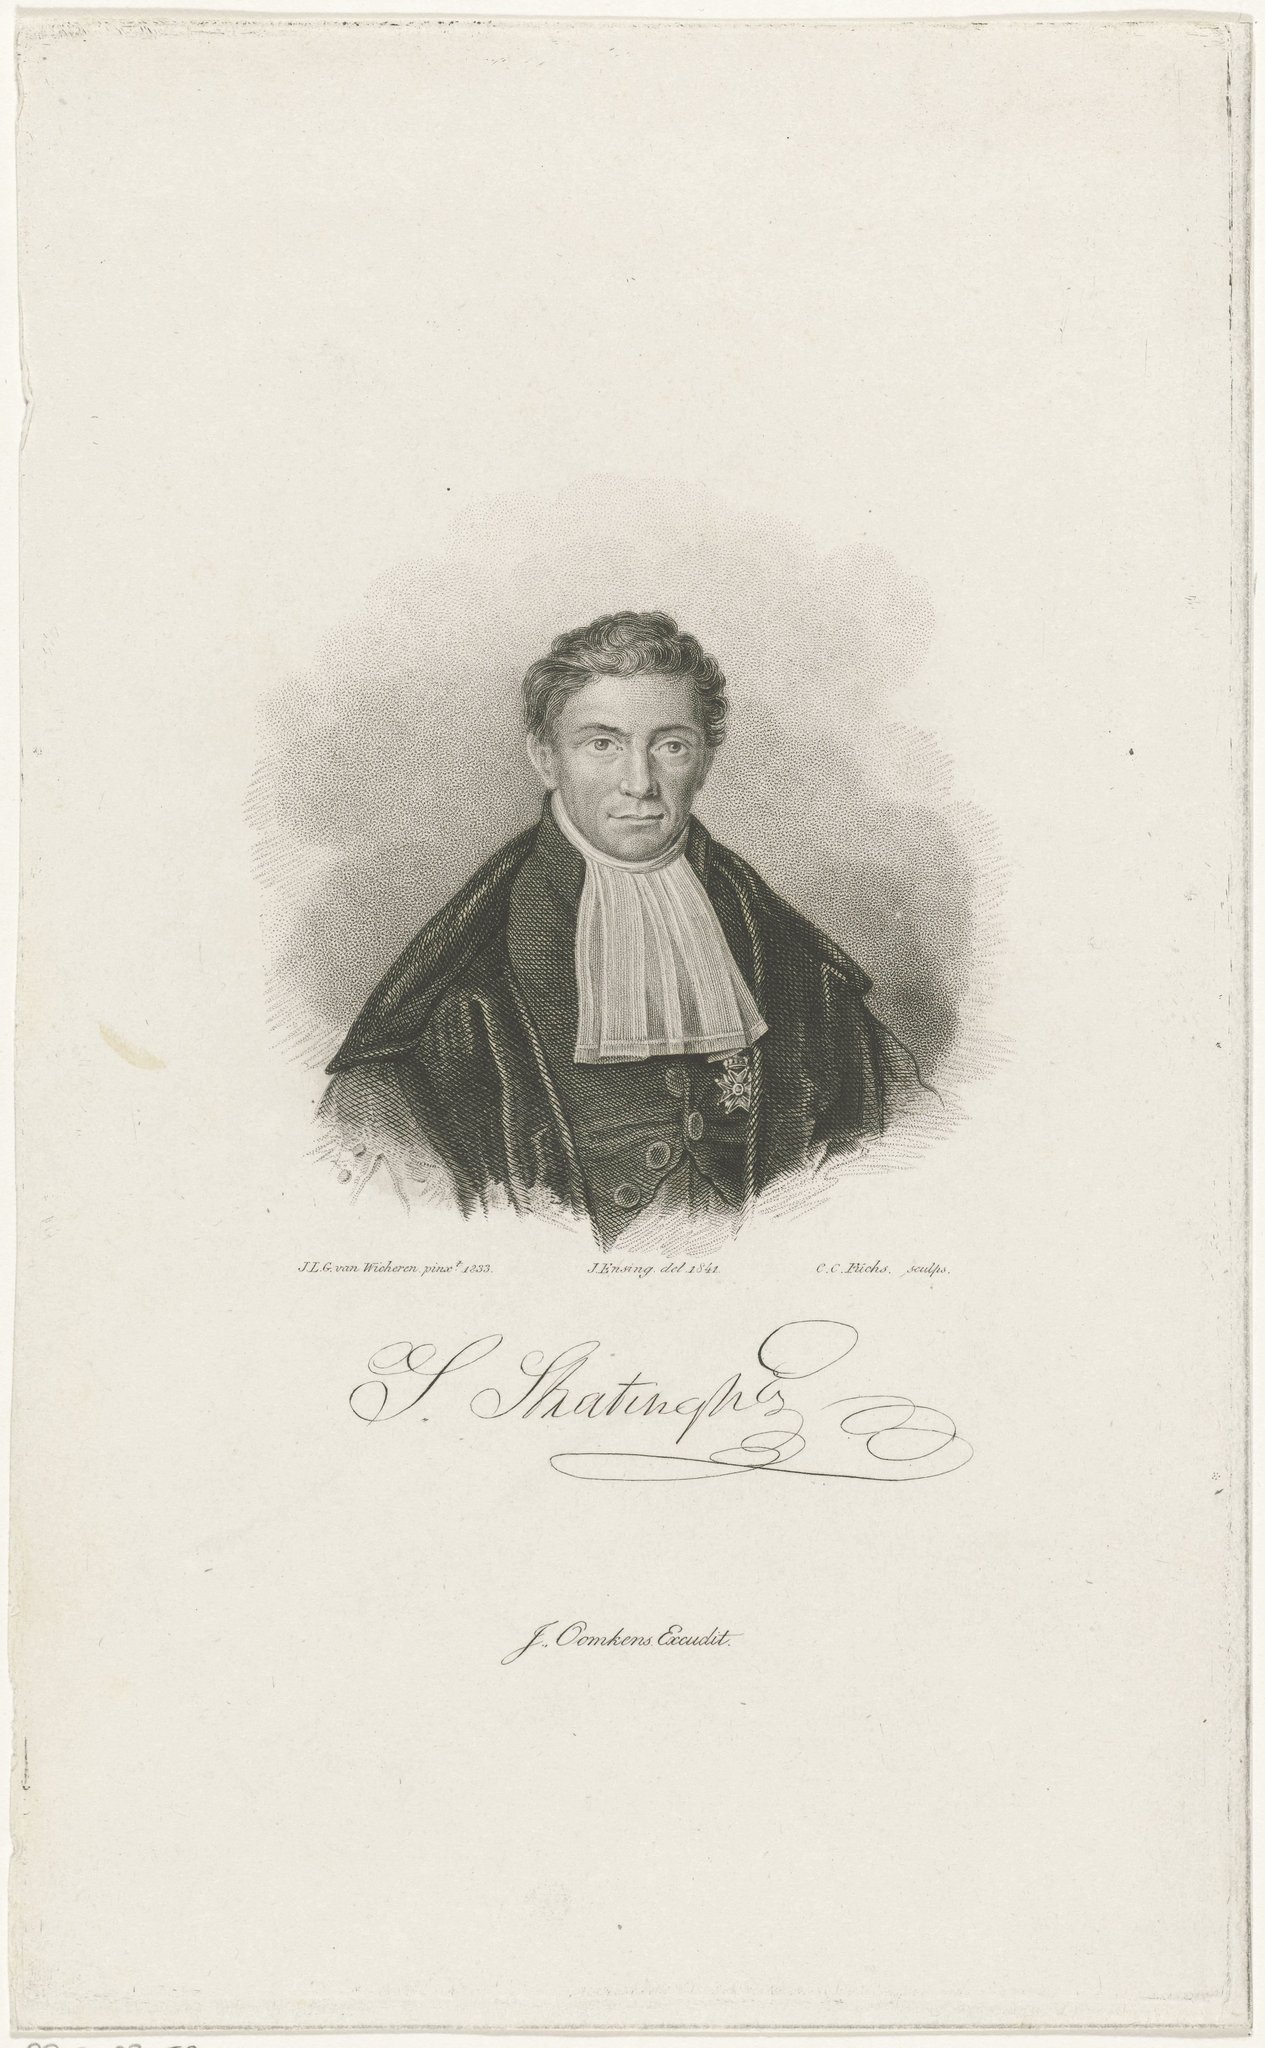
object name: print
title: Portret van Sibrandus Stratingh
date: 1841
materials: paper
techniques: engraving, etching, roulette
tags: adorp, sibrandus stratingh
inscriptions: collector's mark: Lugt 2228